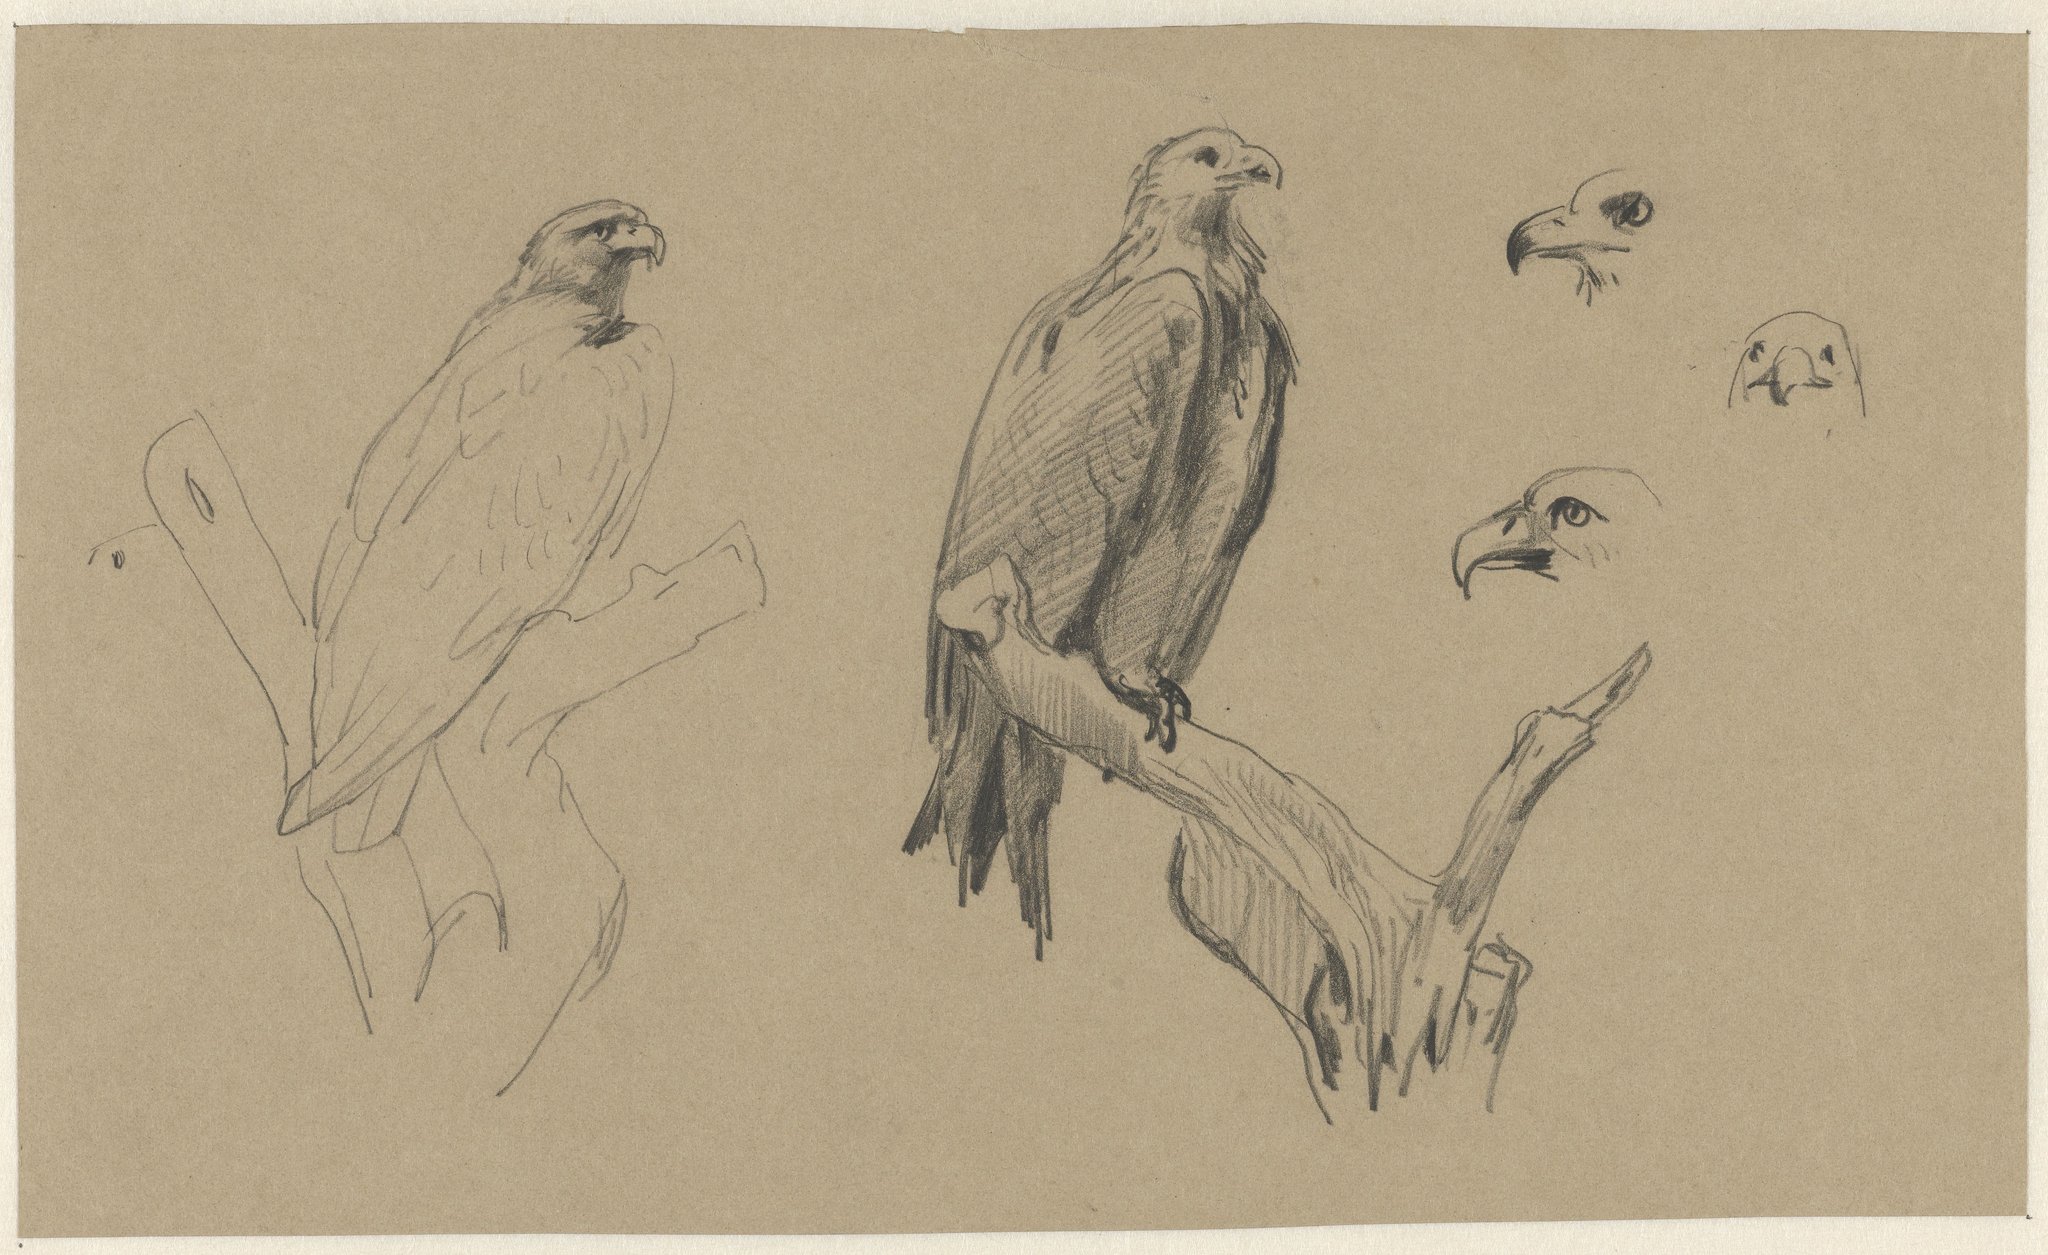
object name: drawing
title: Studies van een arend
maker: guillaume anne van der brugghen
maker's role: draughtsman, print maker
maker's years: 1812-1891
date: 1821-1891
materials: chalk, paper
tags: predatory birds: hawk